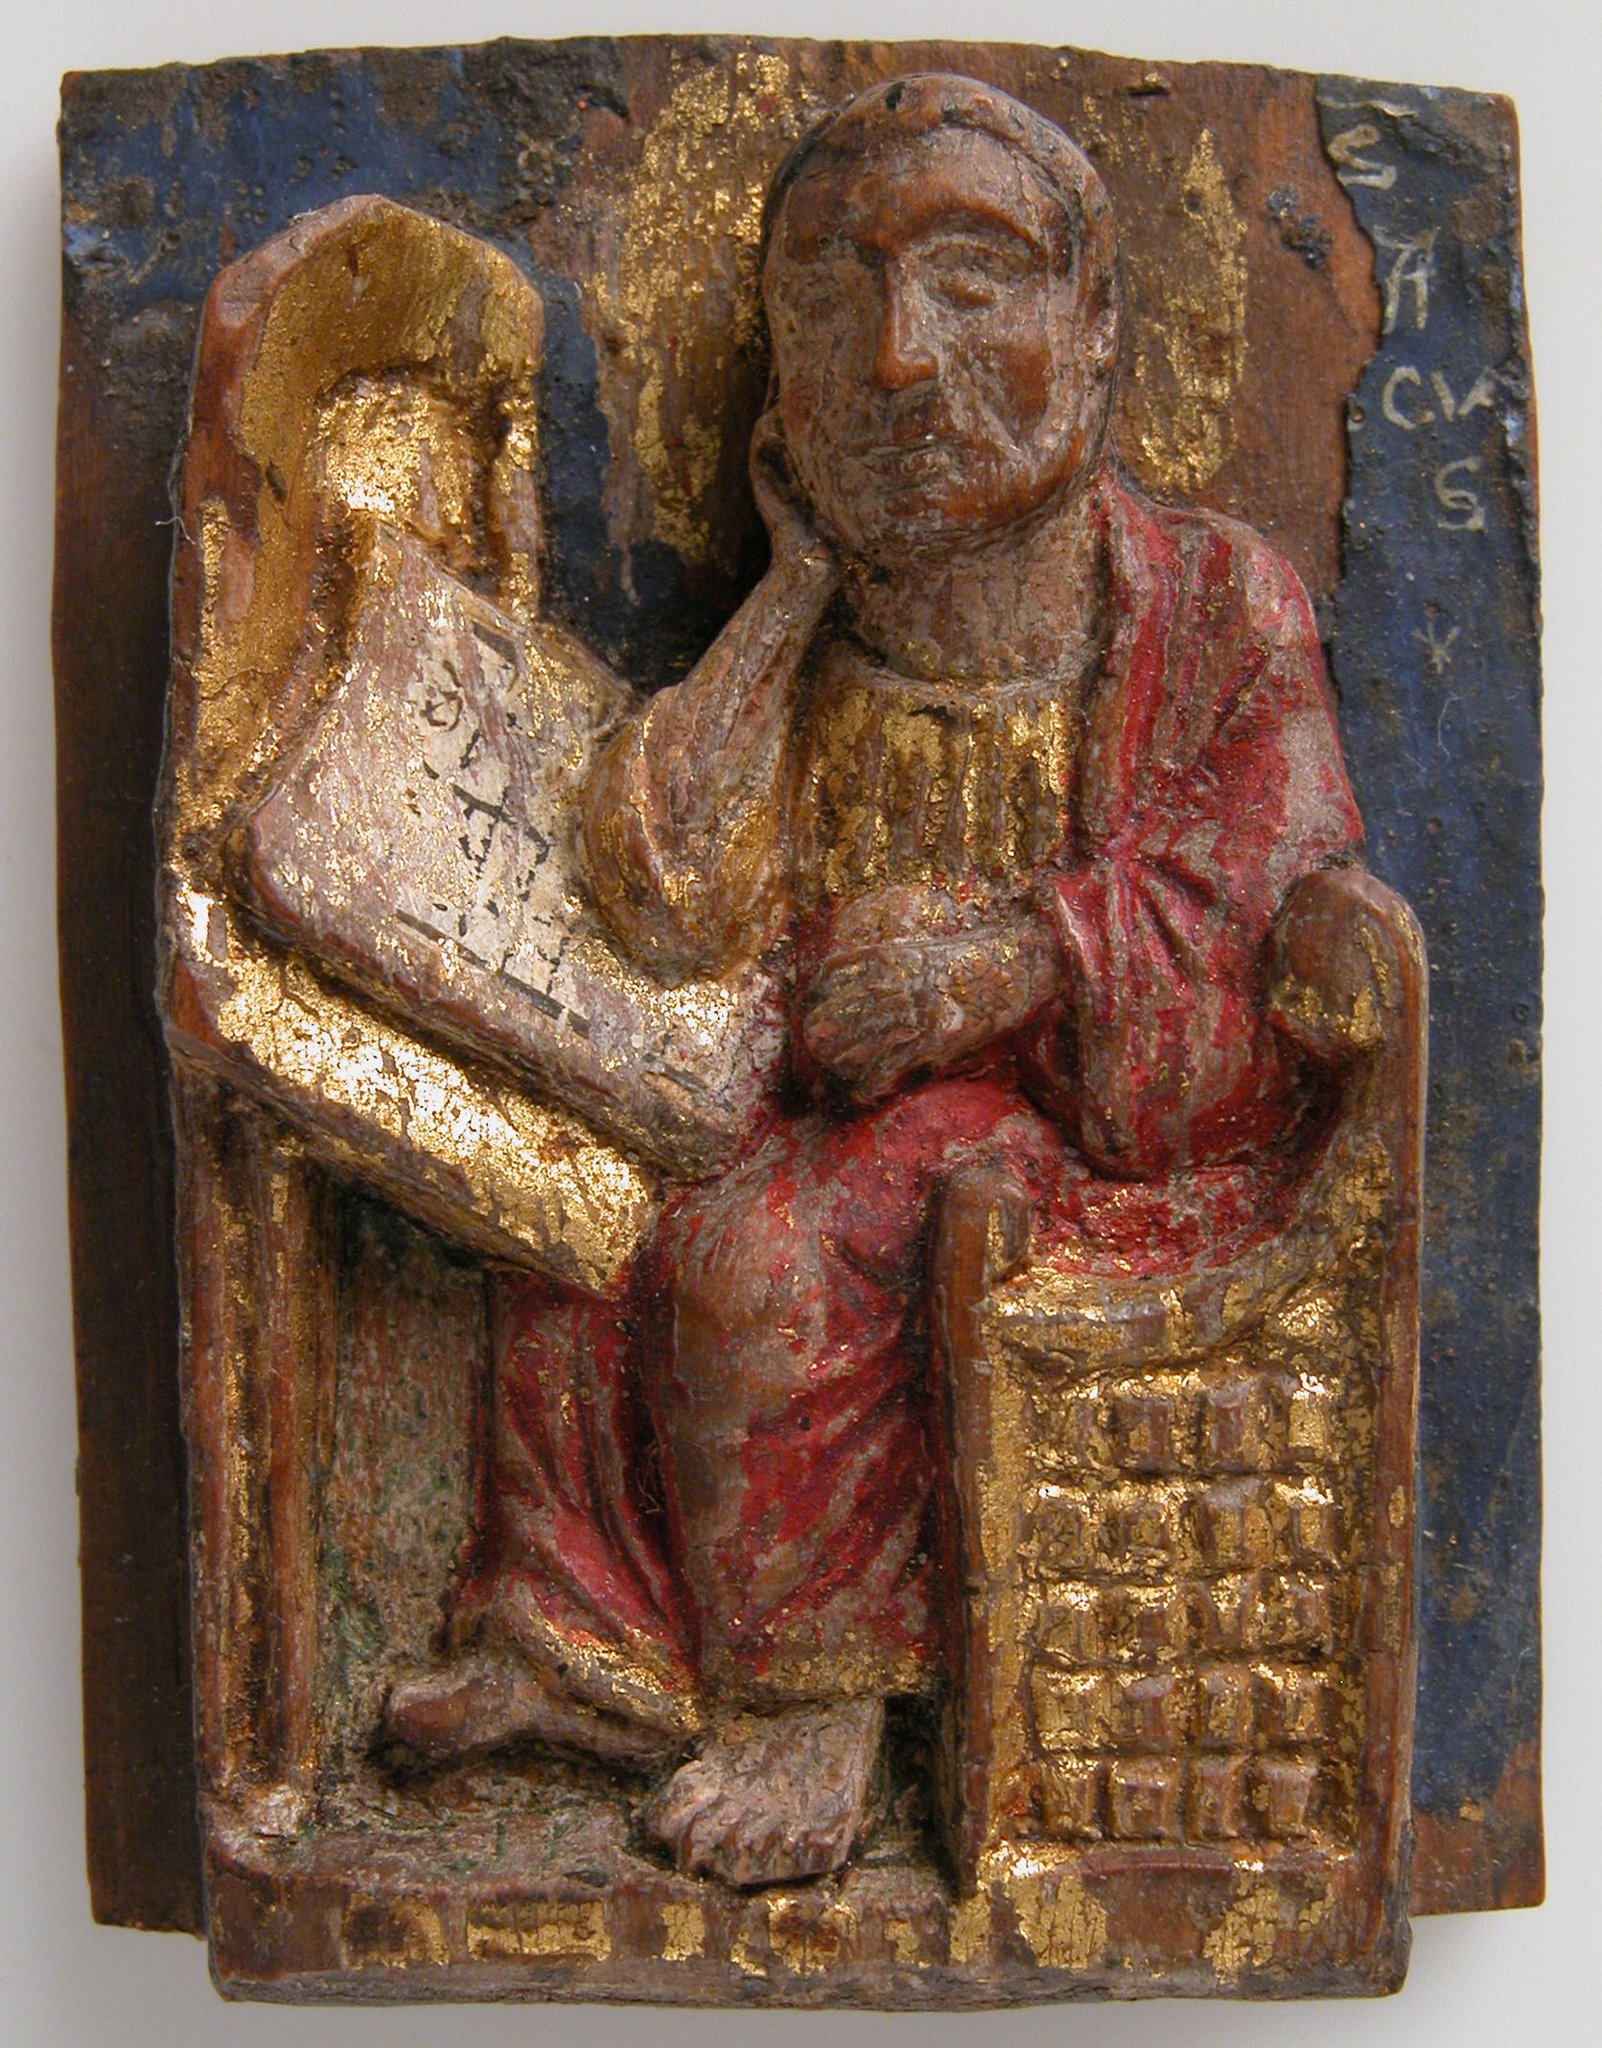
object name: relief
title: Miniature Relief of Saint Mark at His Writing Table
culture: german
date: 1200-1225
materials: wood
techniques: gilding, polychromy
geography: germany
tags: men